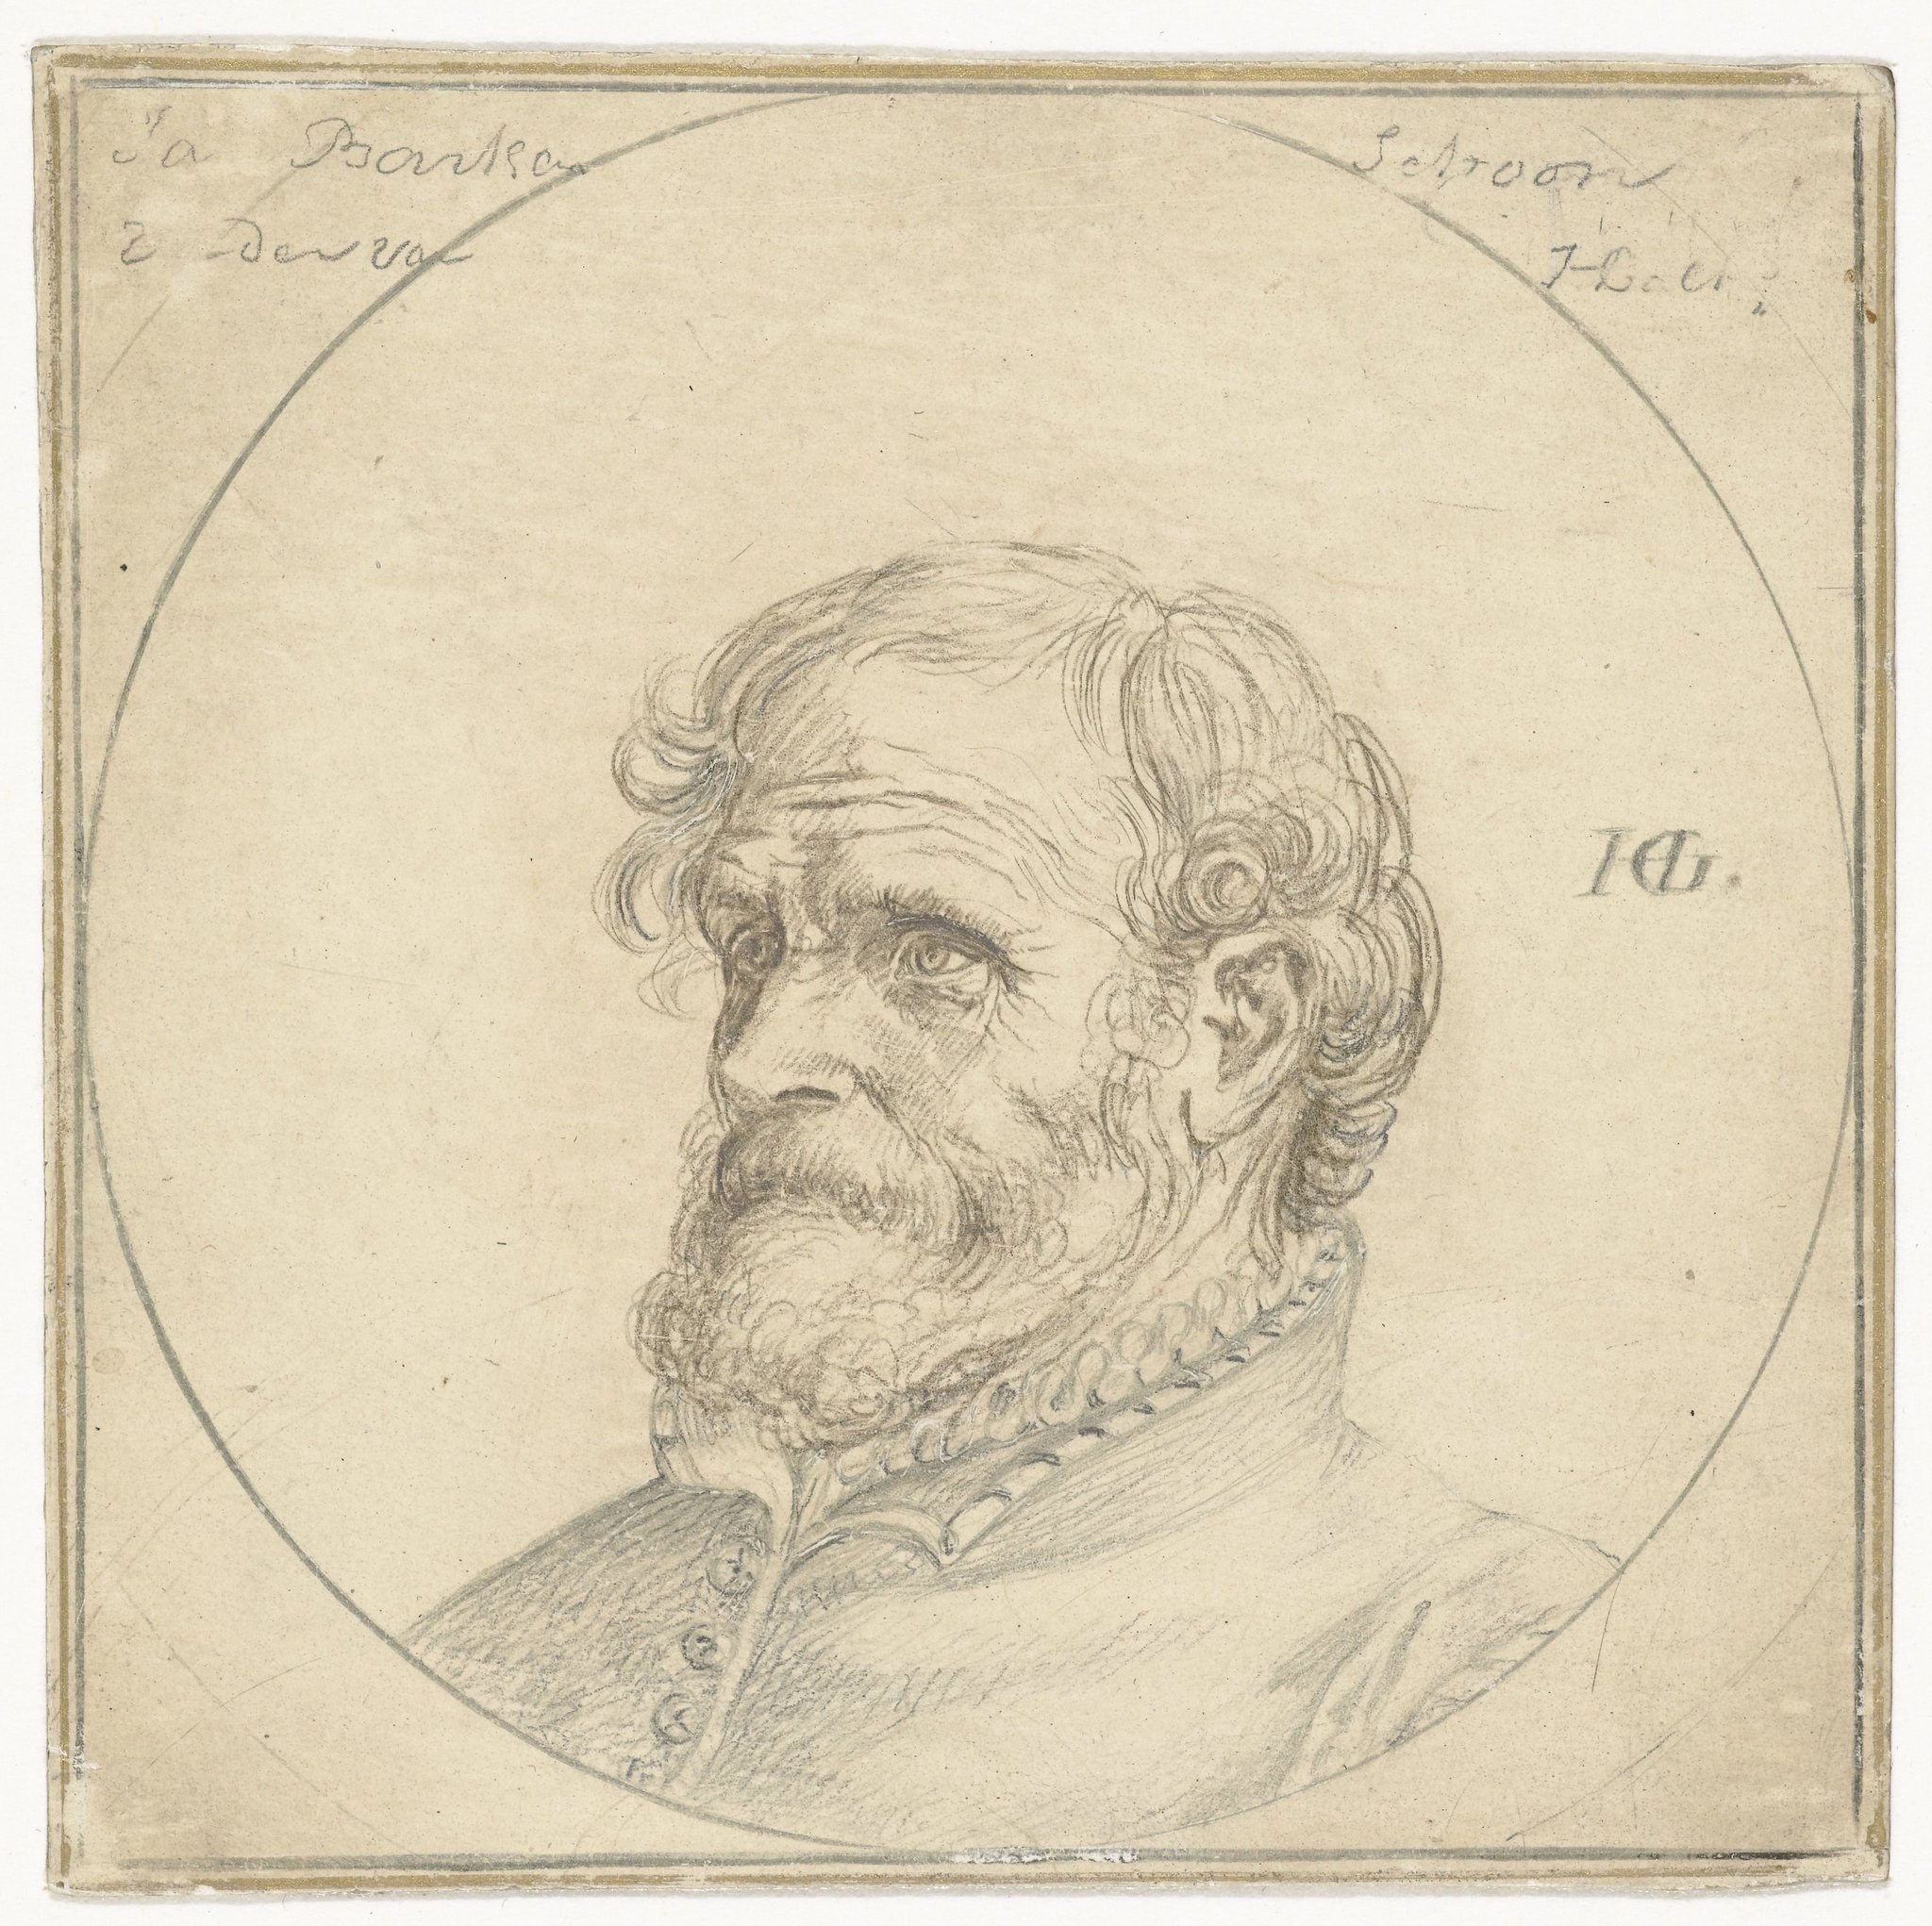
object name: drawing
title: Portret van Jan Baertsen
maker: hendrick goltzius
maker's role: draughtsman, painter, print maker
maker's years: 1558-1617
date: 1587-1591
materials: chalk, paper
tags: historical persons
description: De identificatie van het model zijnde Jan Baertsen, de schoonvader van Goltzius, was reeds vastgesteld voordat het portret in de Ploos van Amstel Collectie werd opgenomen. Dit is bevestigd door de gelijkenis met het portret van hetzelfde model, in Museum Boymans-van Beuningen, van welk de rand inscriptie van het recto uit de zelfde tijd is. Echter, de vergelijking bevestigd niet de autenticiteit van onze tekening, waaraan Langerhuizen schijnt te twijfelen.